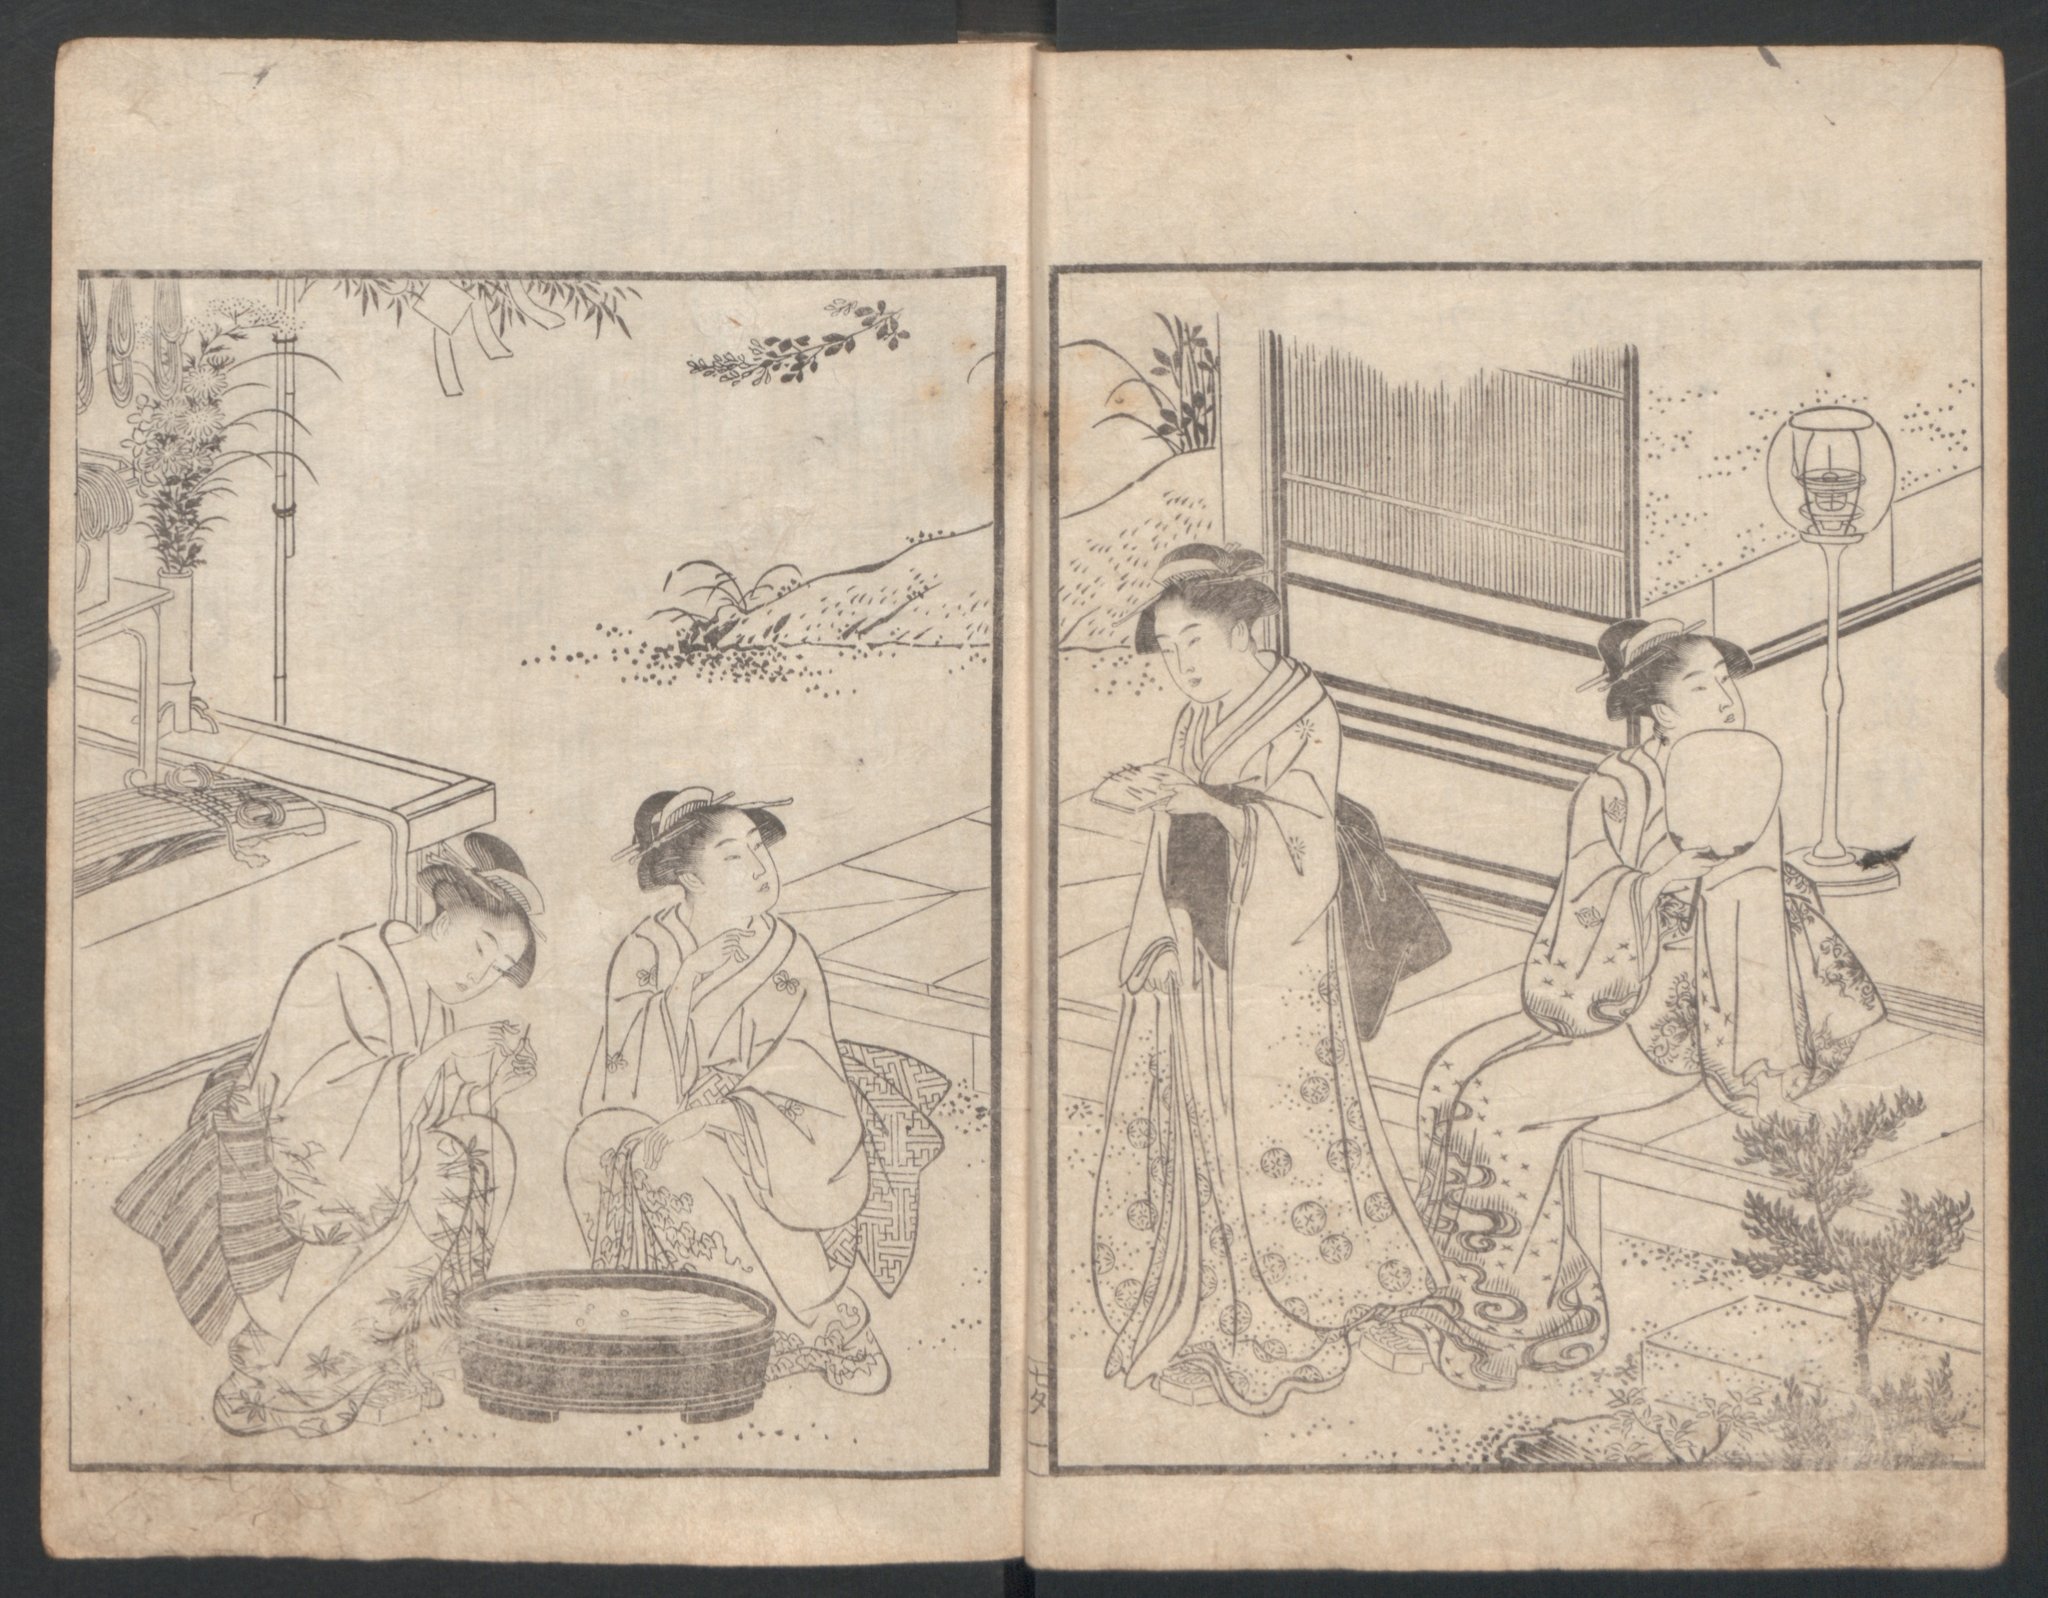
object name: illustrated book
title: Illustrated Book of Kyōka (comic poems) "Maple Bridge" (Ehon momiji bashi) 絵本紅葉橋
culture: japanese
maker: katsukawa shunchō 勝川春潮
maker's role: artist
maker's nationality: japanese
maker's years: 1775-1795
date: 1790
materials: ink, paper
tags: houses,women